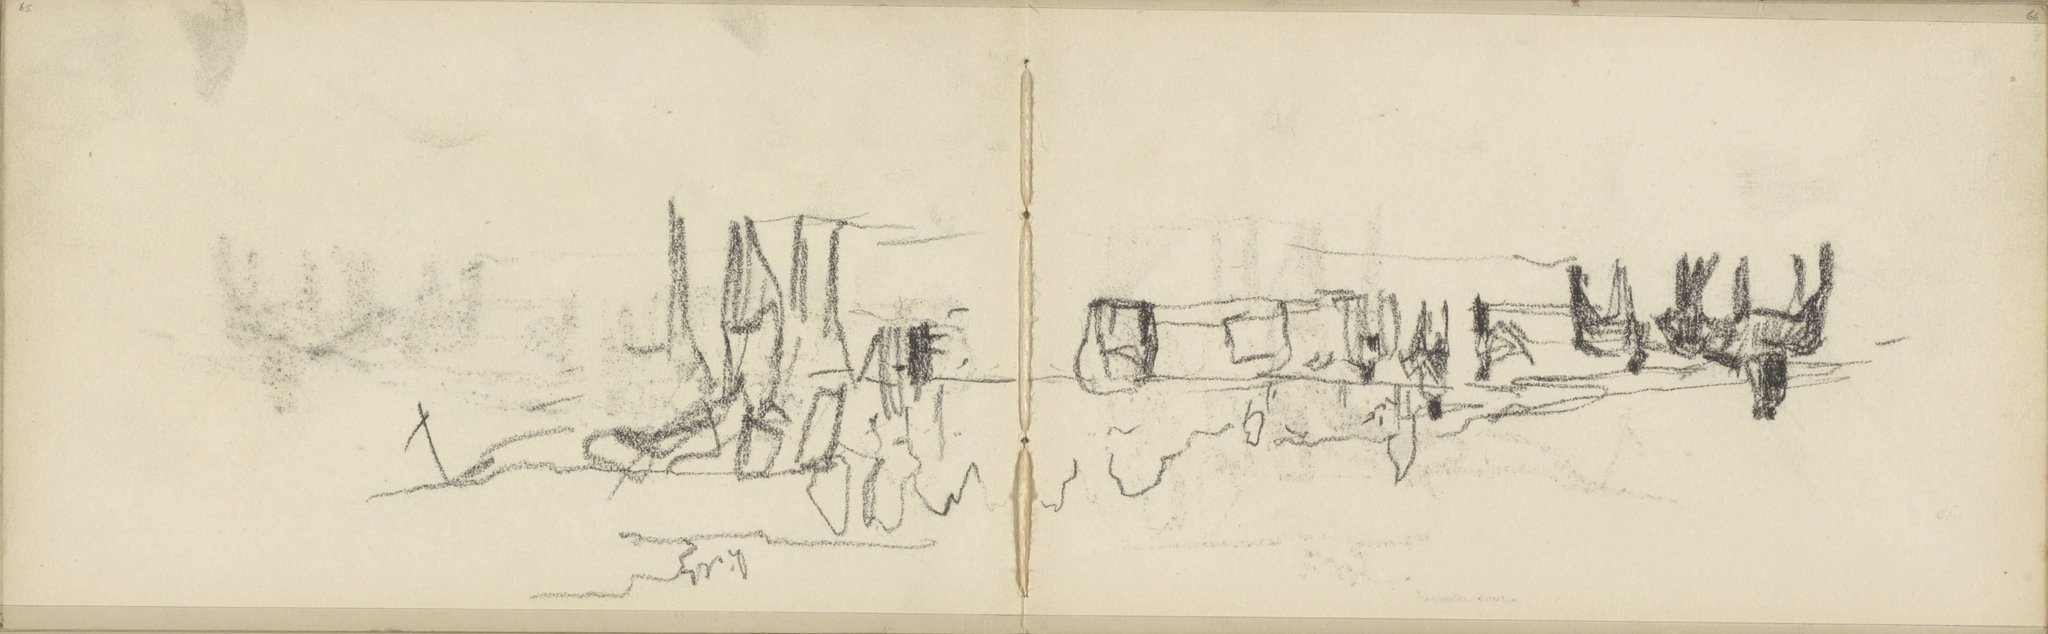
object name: sketchbook leaf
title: Landschap met bereden artilleristen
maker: george hendrik breitner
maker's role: draughtsman, painter, print maker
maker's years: 1857-1923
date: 1884-1886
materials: chalk, paper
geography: the hague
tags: land forces (+ artillery), landscapes, horse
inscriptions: kleurnotitie, handgeschreven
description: Pagina 65 en pagina 66 uit een schetsboek met 35 bladen.